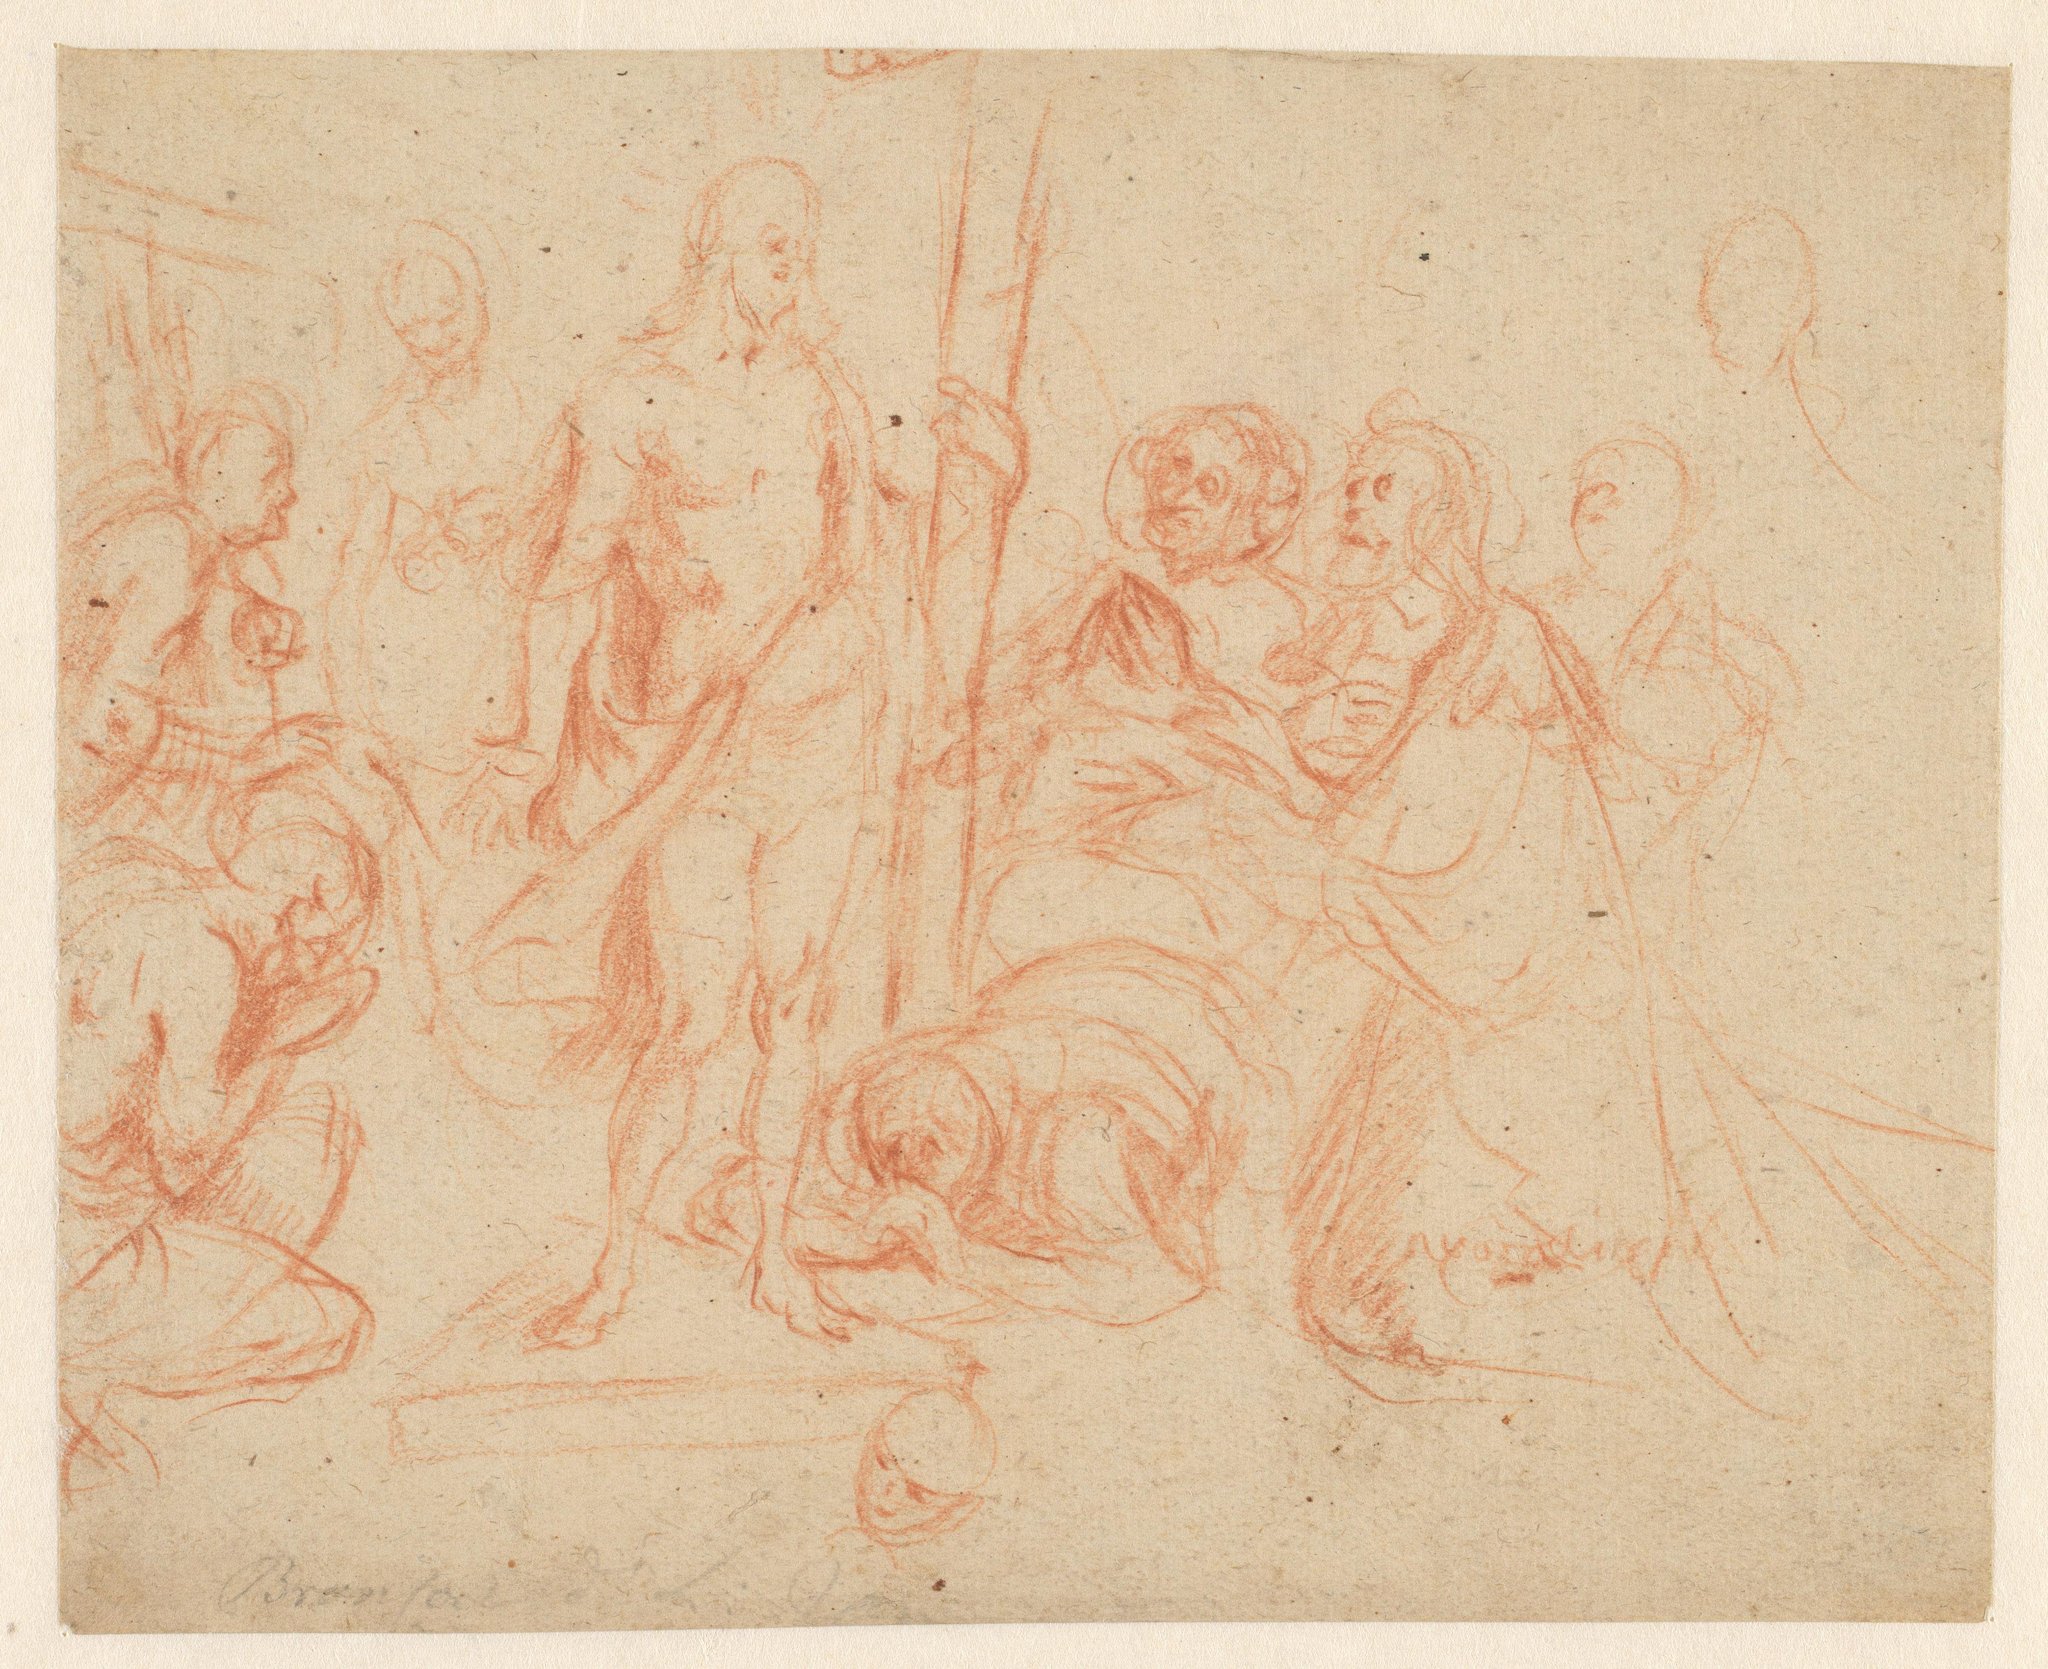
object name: drawing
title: Christus met het kruis, omringd door knielende figuren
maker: jan gerritsz. van bronckhorst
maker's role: draughtsman, painter, print maker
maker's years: 1603-1661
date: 1613-1677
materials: chalk, paper